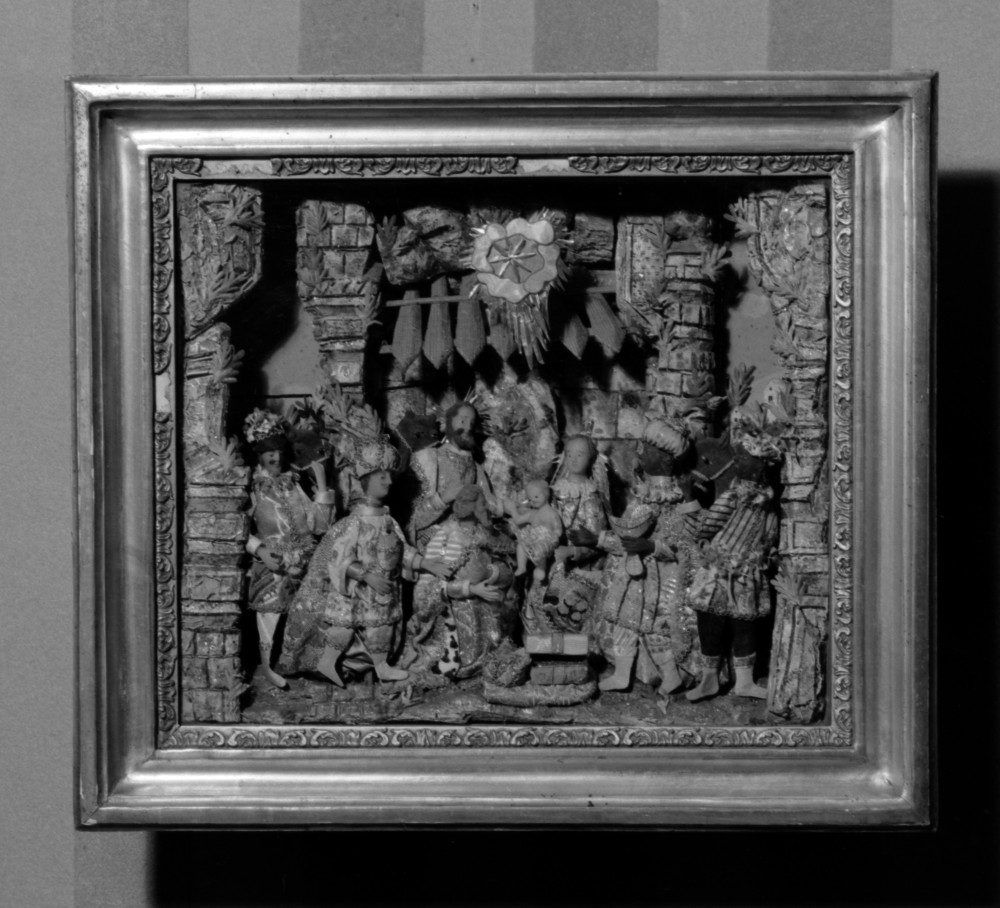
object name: relief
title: Adoration of the Magi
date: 1701-1800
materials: glass, wax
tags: adoration of the magi